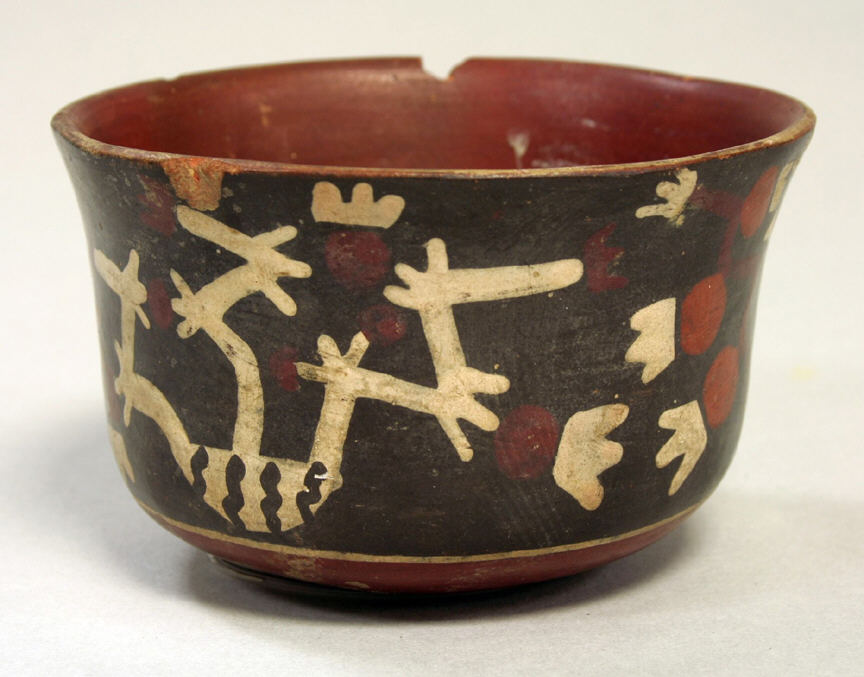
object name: bowl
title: Painted Bowl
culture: nasca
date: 1-600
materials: ceramic, pigment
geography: peru